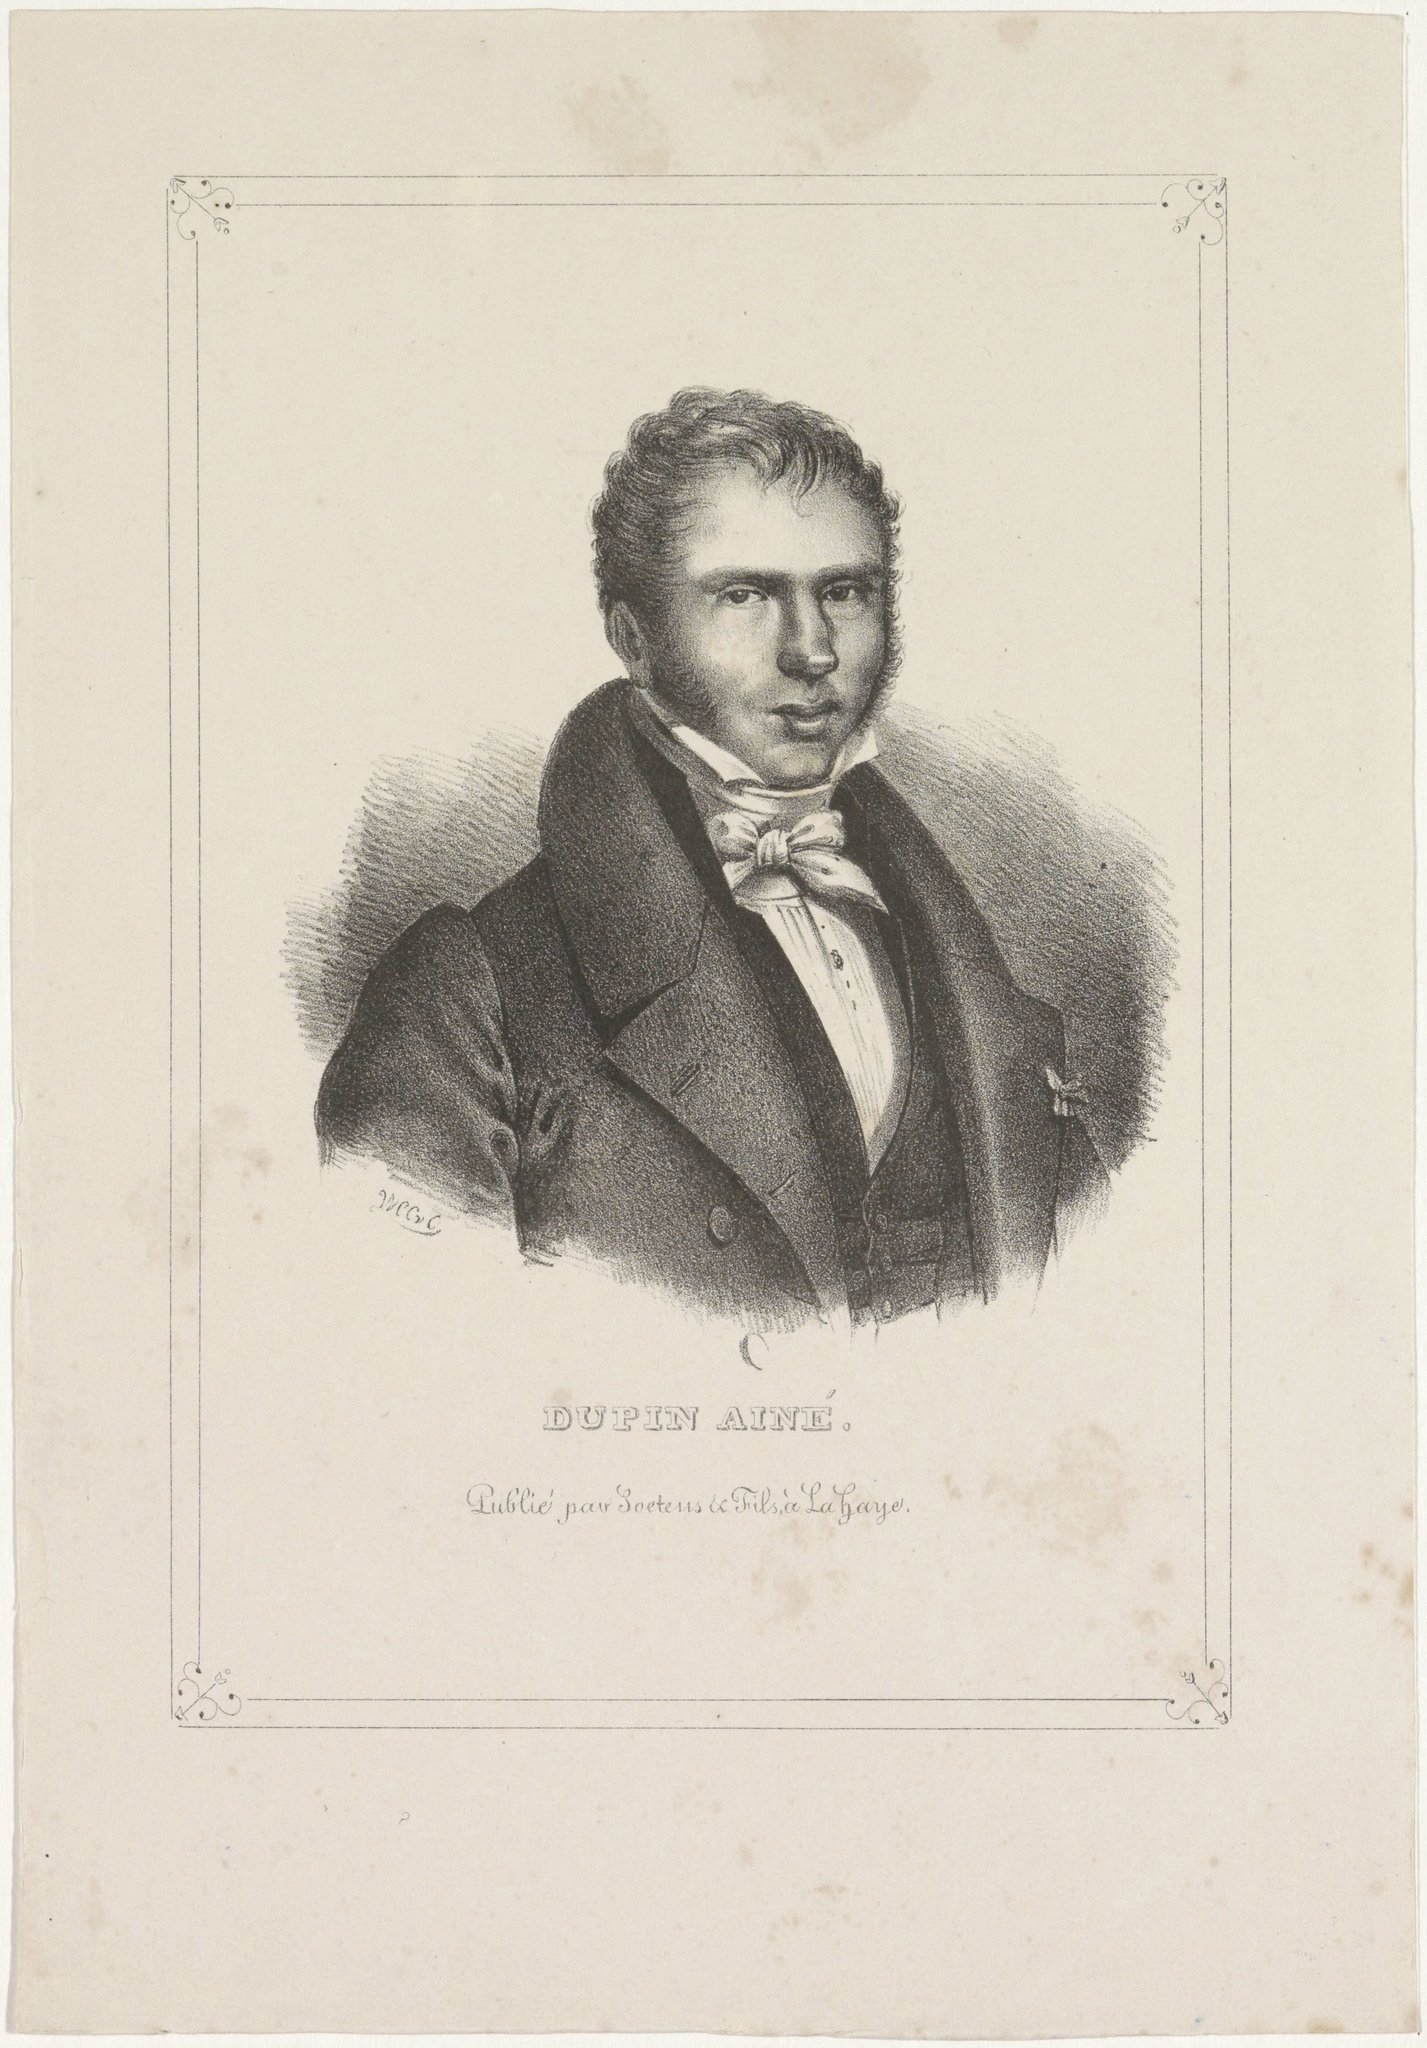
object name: print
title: Portret van André Marie Jean Jacques Dupin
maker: wilhelmus cornelis chimaer van oudendorp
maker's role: print maker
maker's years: 1822-1873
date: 1837-1840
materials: paper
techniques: lithograph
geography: the hague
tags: paris, historical persons (+ head (and shoulders) (portrait))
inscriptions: collector's mark: Lugt 2228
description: De geportretteerde draagt een open jas en een gestrikte das. Op de revers van zijn jas draagt hij een onderscheiding. Onder het portret zijn naam.